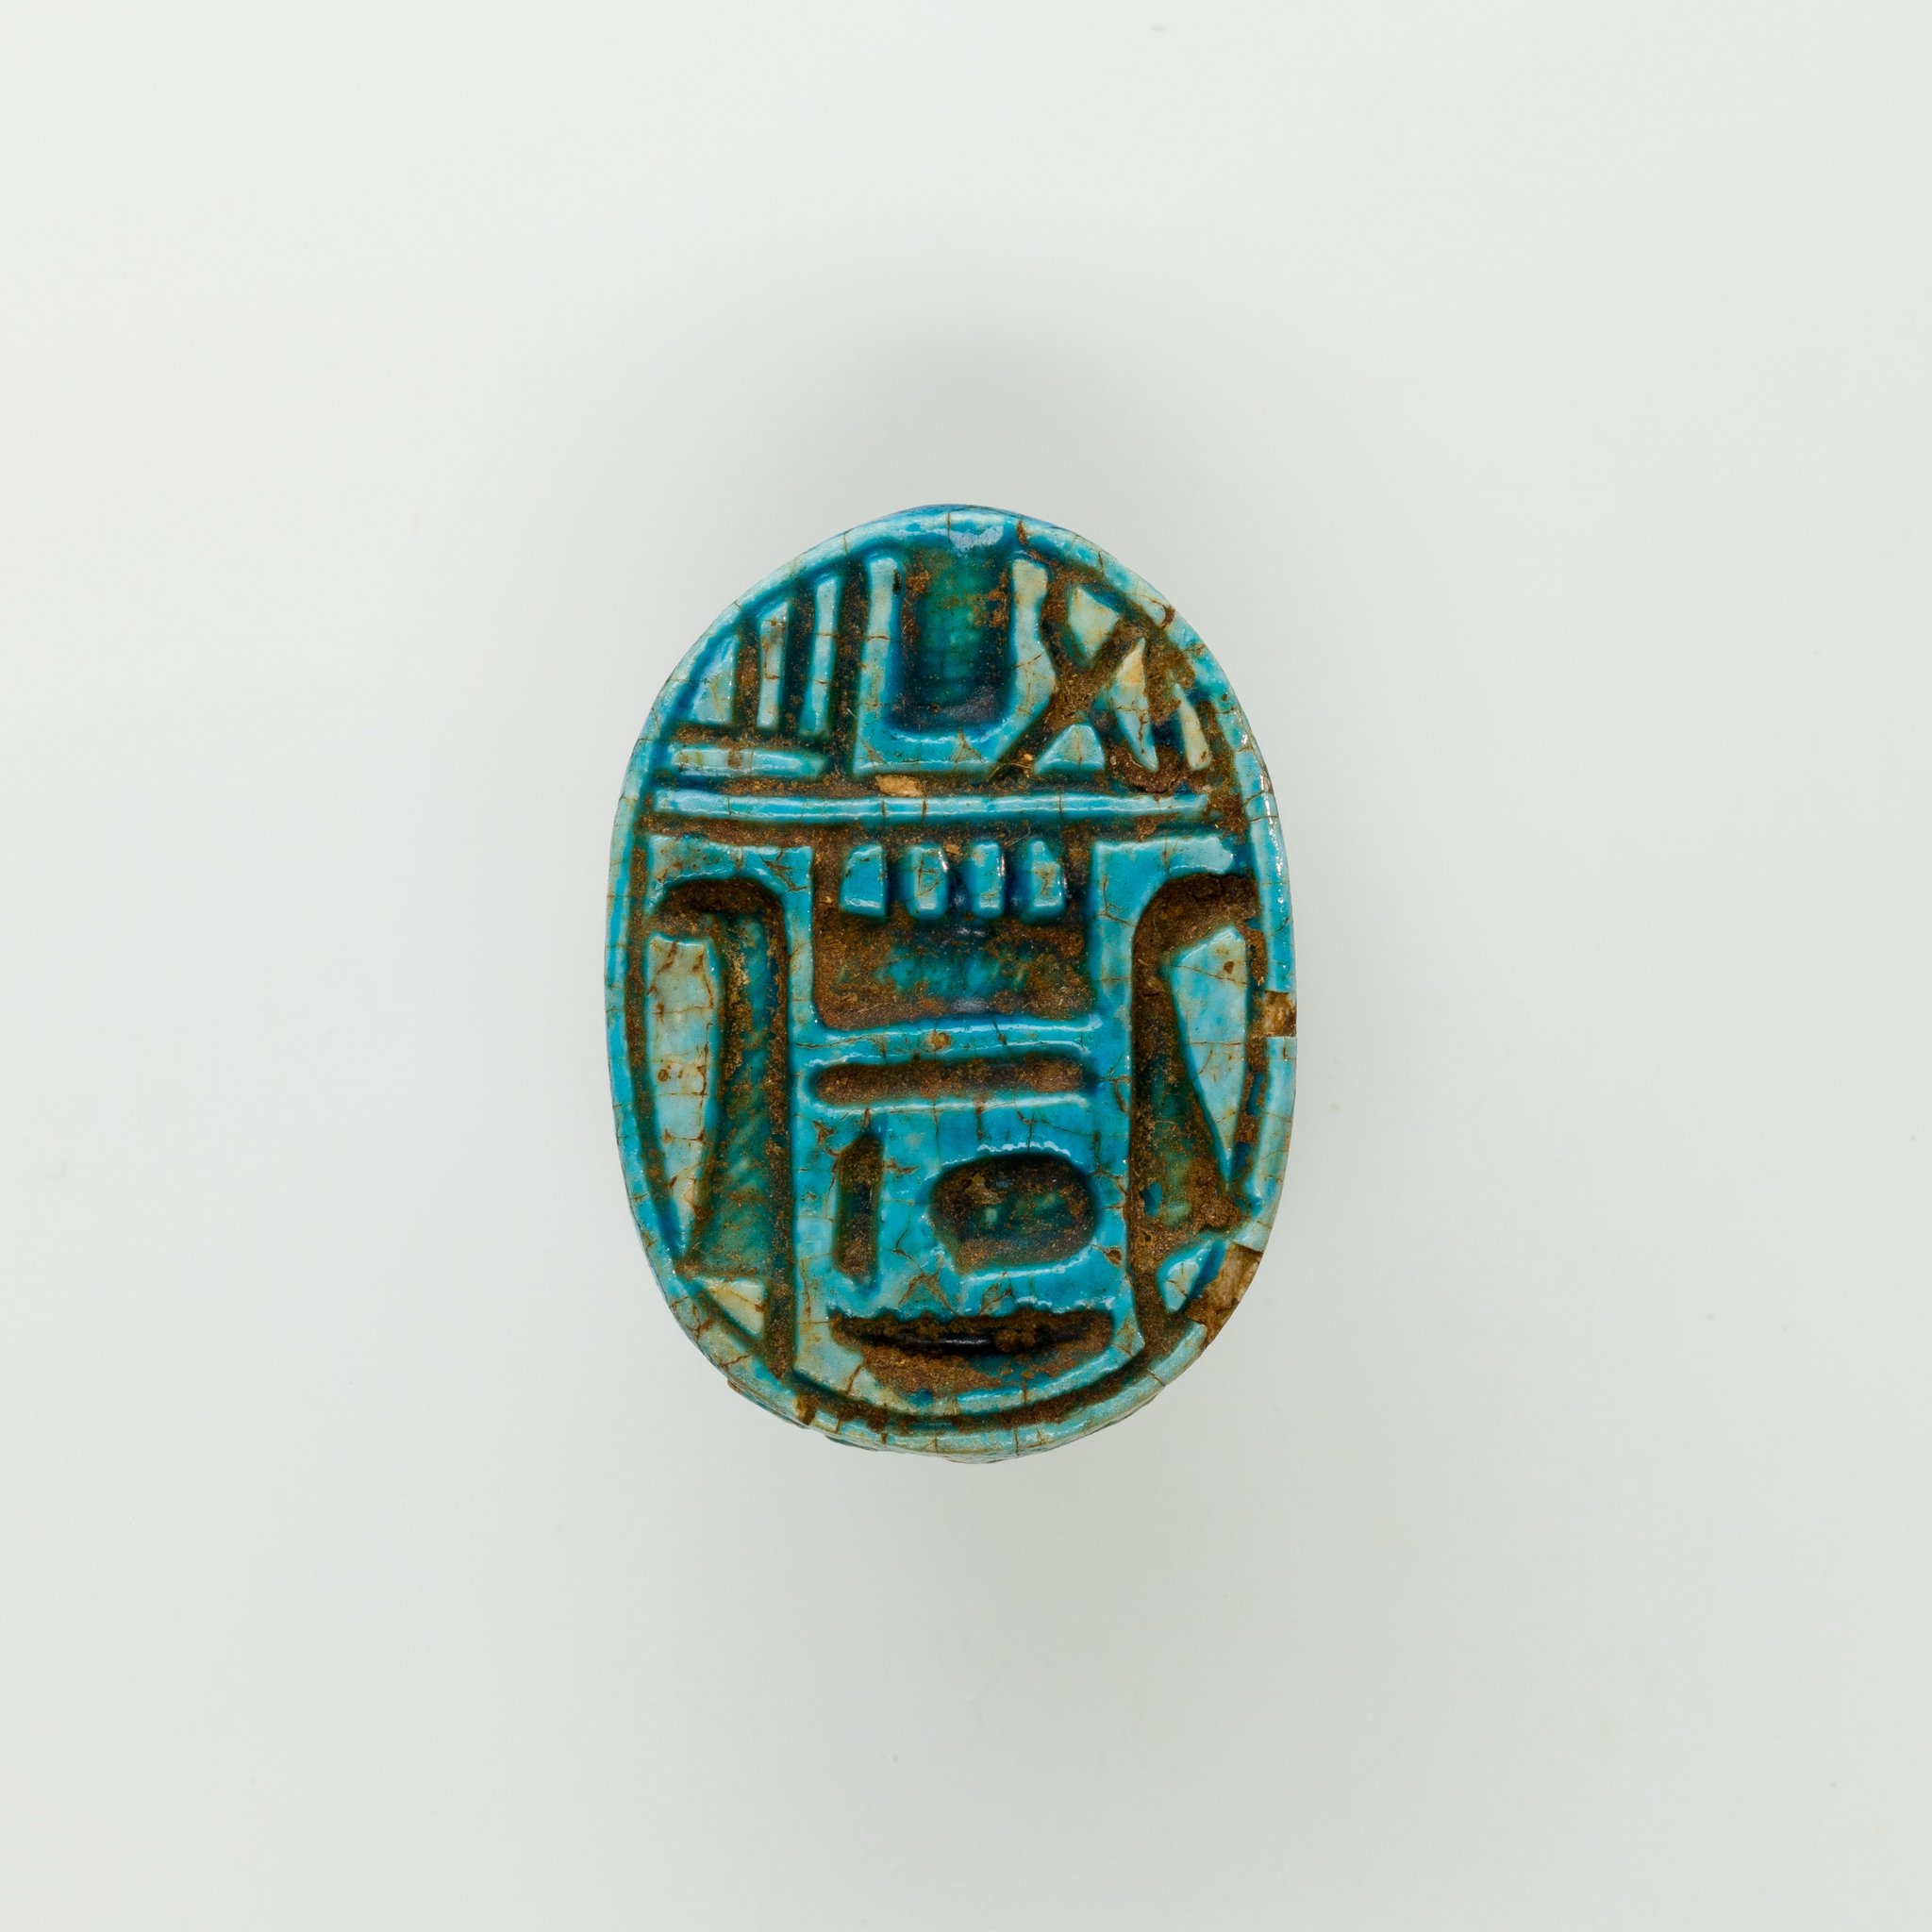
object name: scarab, ramesses ii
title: Scarab of Ramesses II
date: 1295-1070 BCE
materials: stone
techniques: glazing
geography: egypt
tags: scarabs